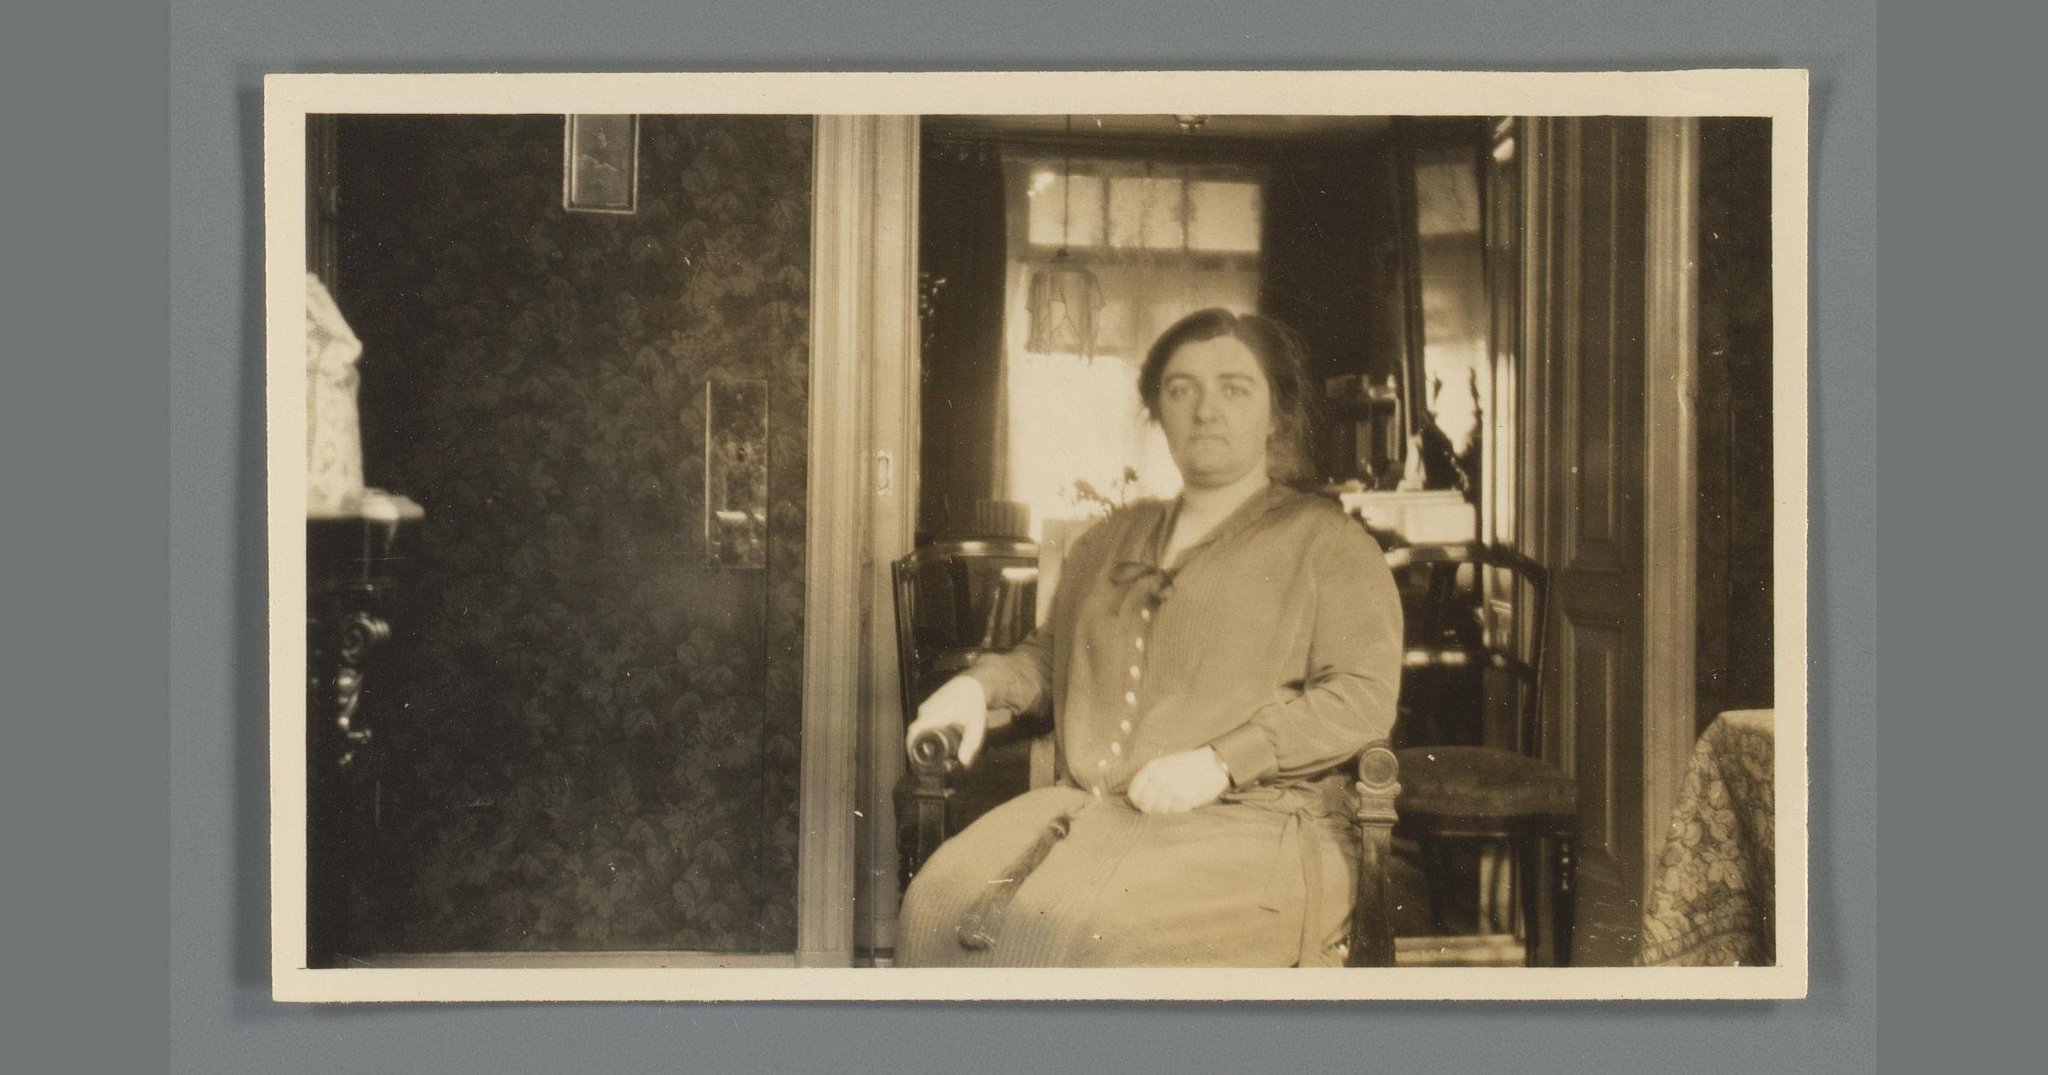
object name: photograph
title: Portret van een onbekende vrouw in een interieur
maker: Anonymous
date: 1920-1940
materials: paper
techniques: gelatin silver print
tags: historical persons not known by name - bb - woman